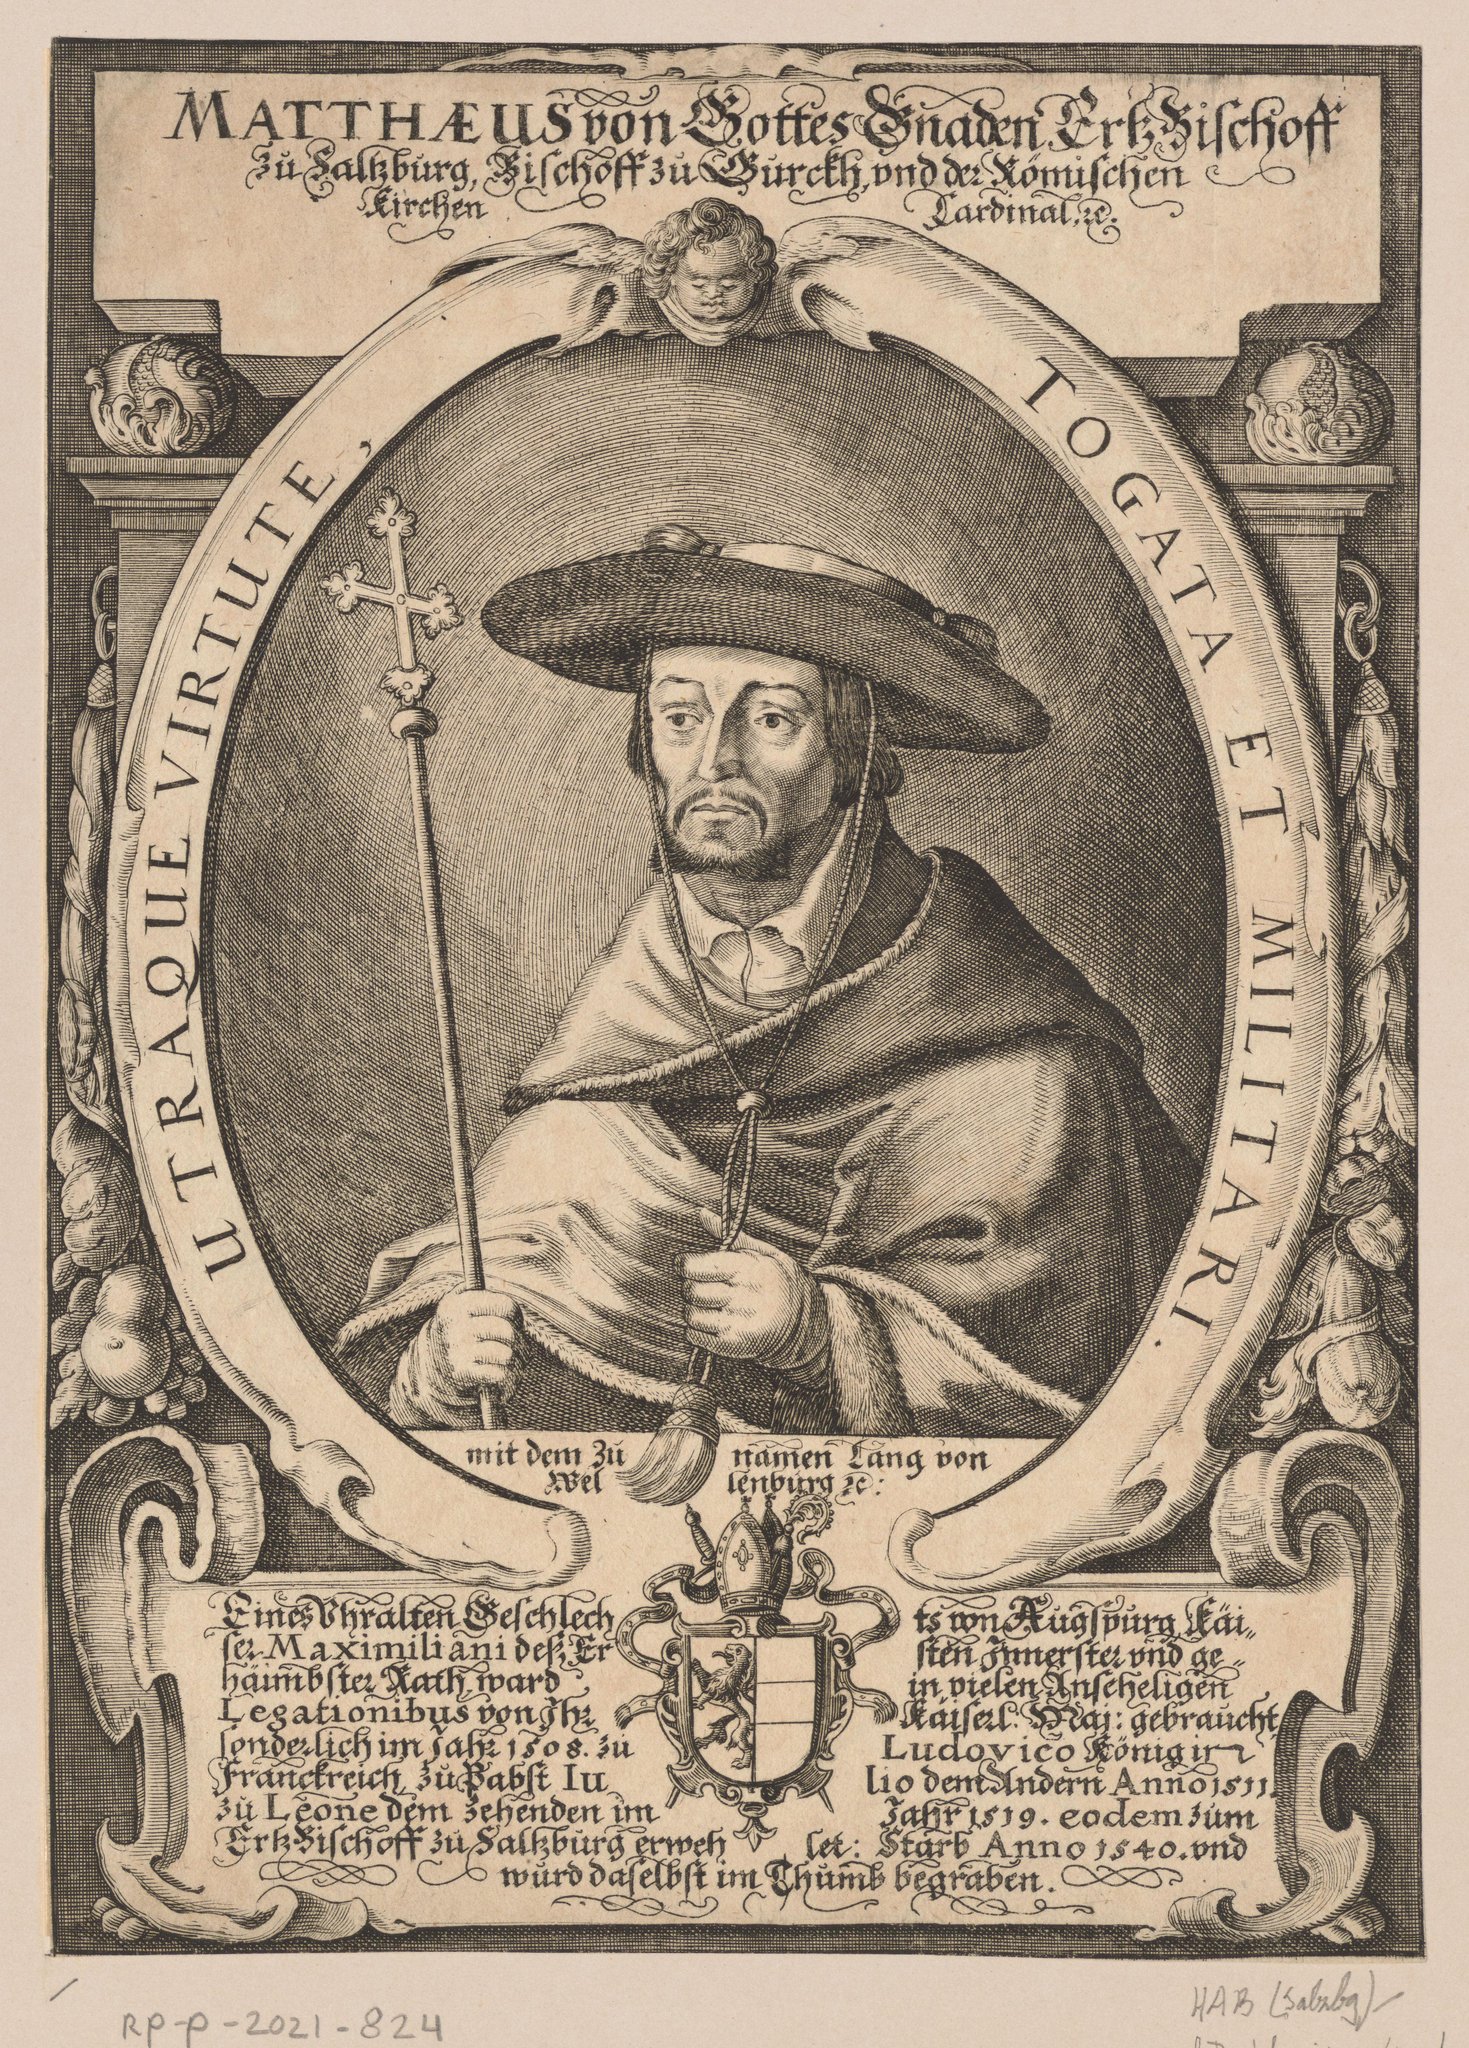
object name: print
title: Portret van Matthäus Lang von Wellenburg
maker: Anonymous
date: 1600-1699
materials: paper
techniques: engraving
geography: germany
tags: augsburg, matthäus lang von wellenburg, cherubs, i.e. children's heads with wings, cardinal, historical persons, insignia of cardinal, e.g. hat, mantle, armorial bearing, heraldry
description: Met boven en onder het portret tekst in het Duits.